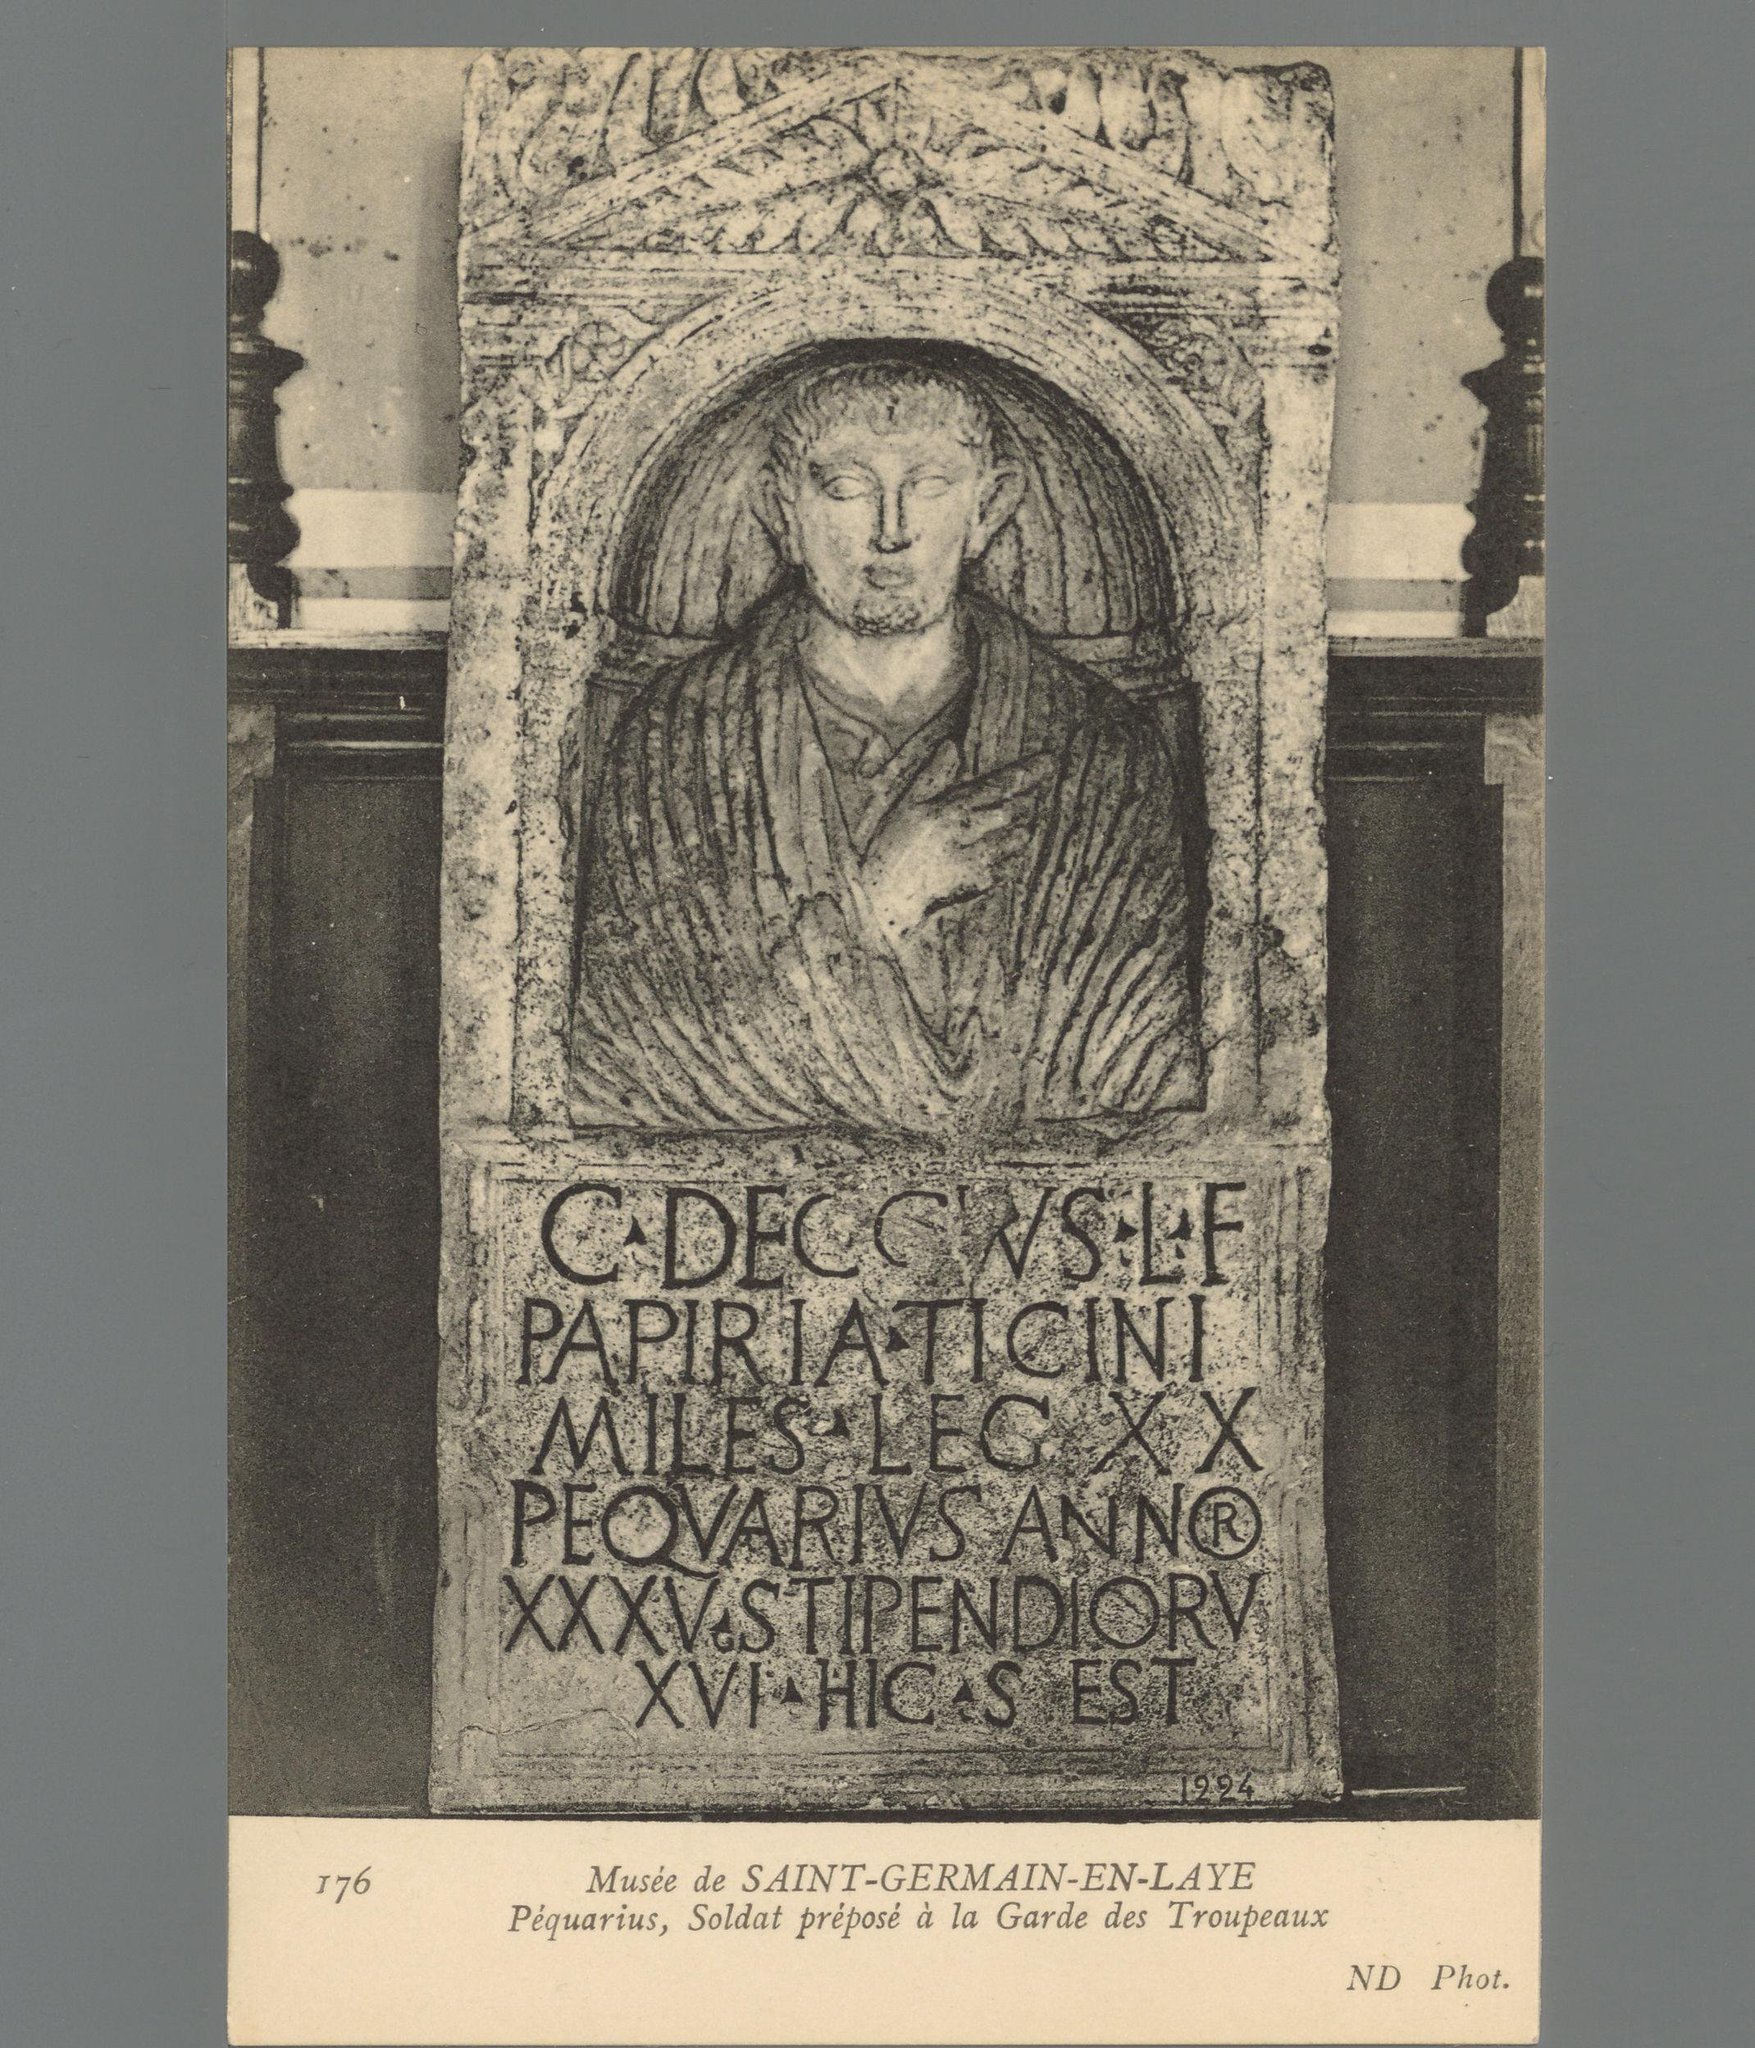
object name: photomechanical print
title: Musée de Saint-Germain-en-Laye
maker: Anonymous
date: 1904-1906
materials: cardboard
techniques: photograph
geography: paris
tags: monument, statue, permanent exhibition, museum